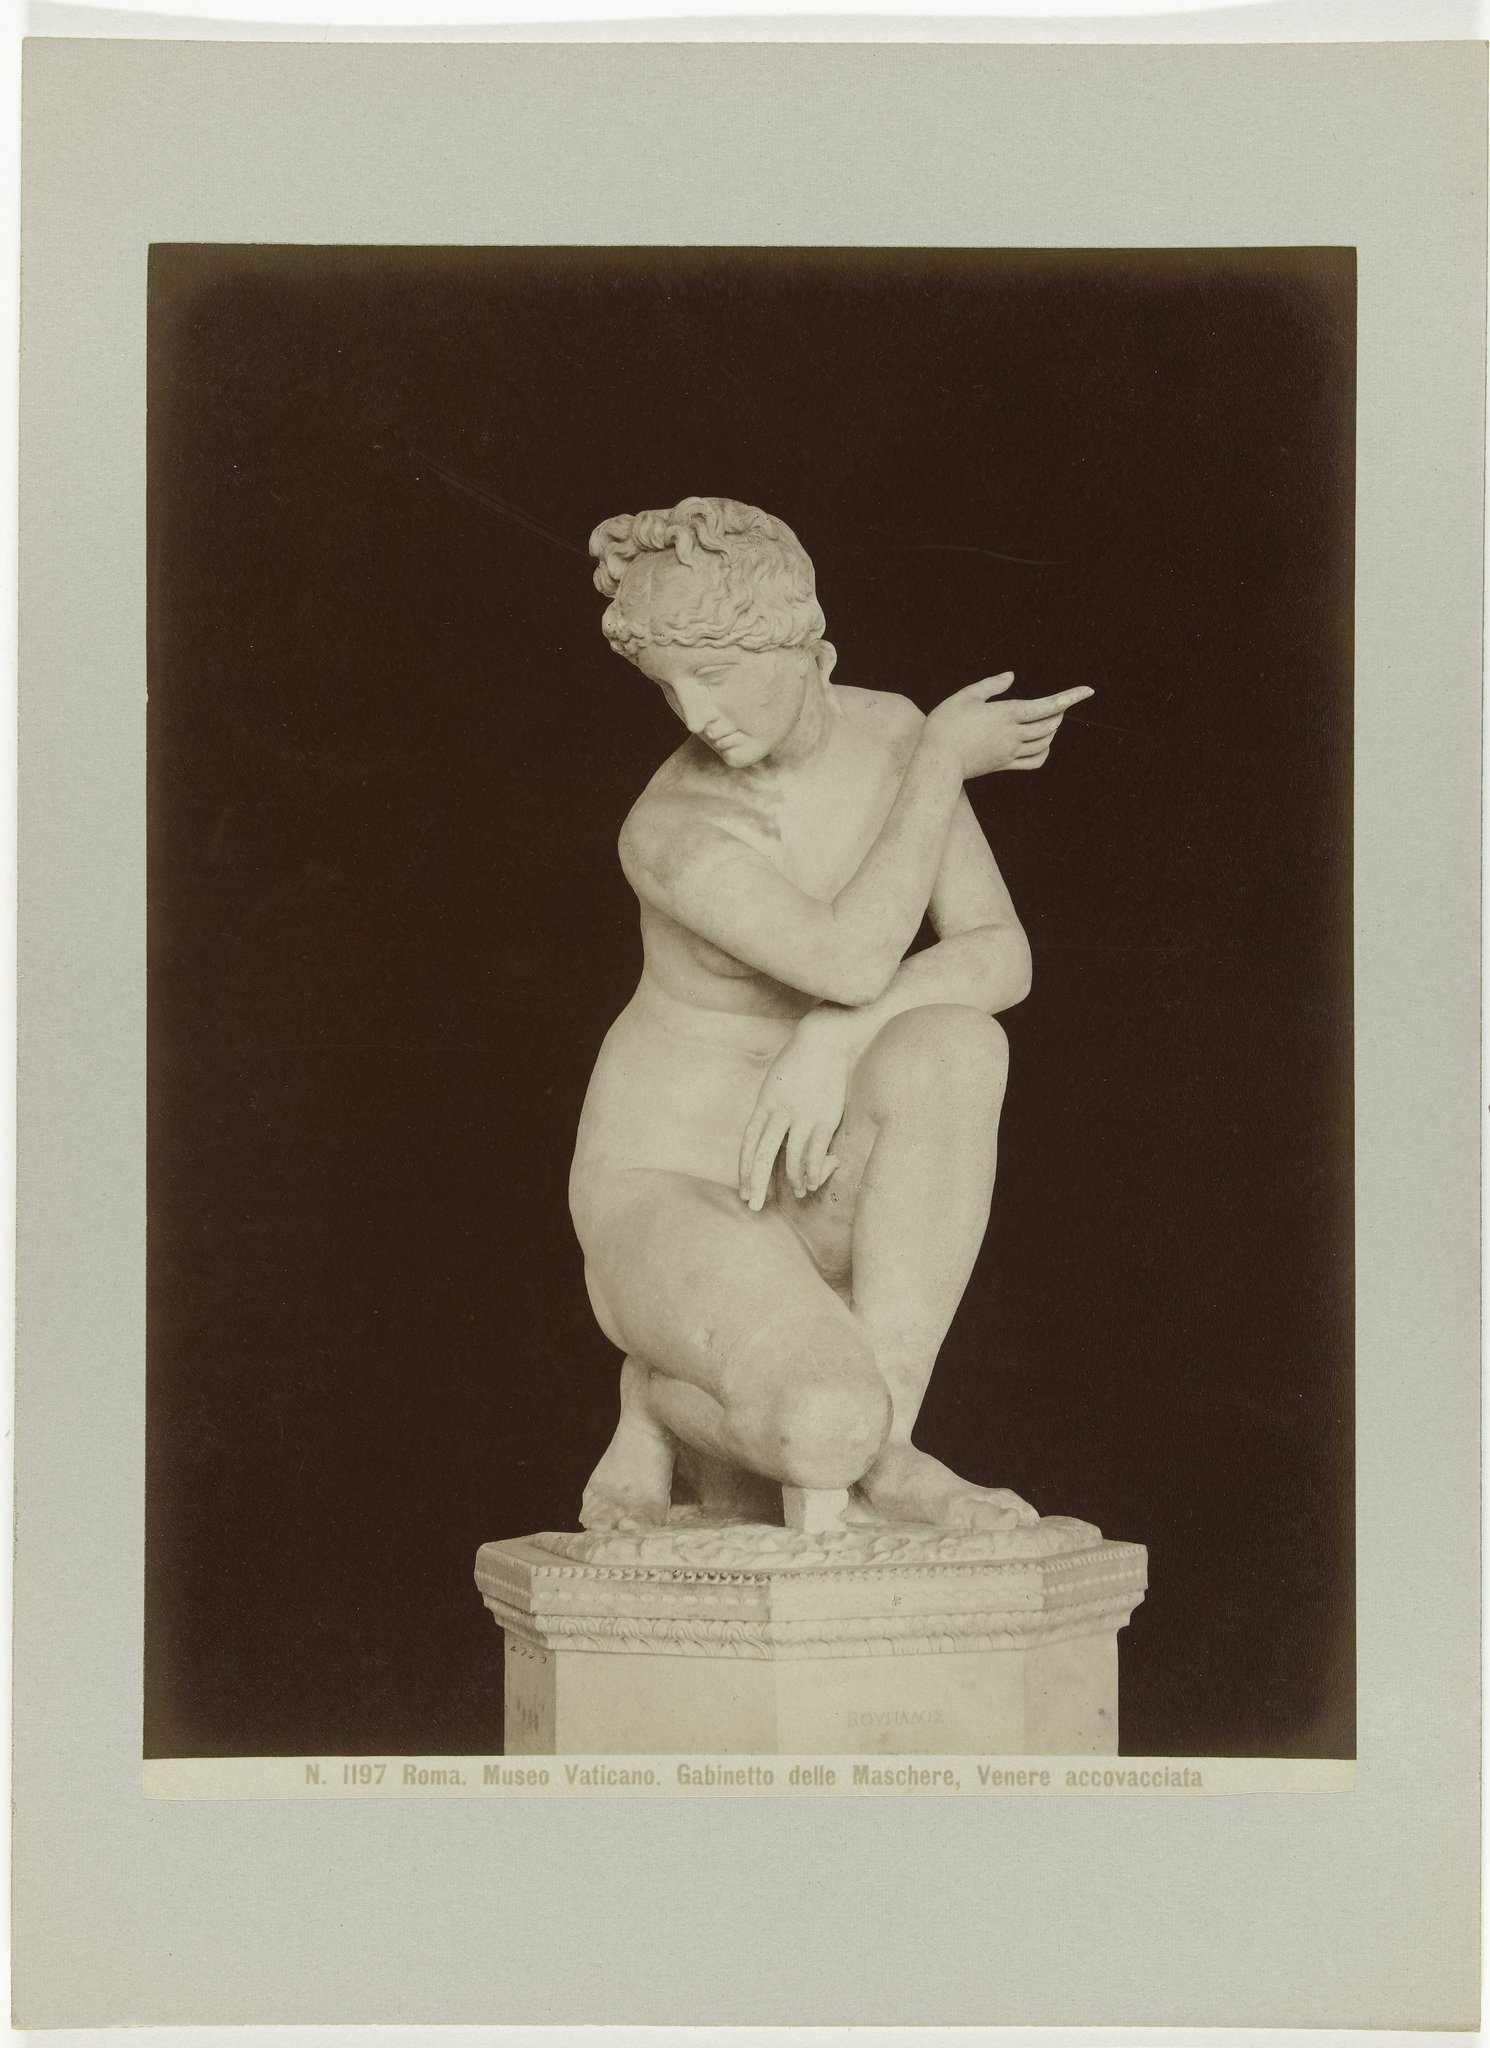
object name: photograph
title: Sculptuur van hurkende Venus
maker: Anonymous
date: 1880-1904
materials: cardboard, paper, photographic support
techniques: albumen print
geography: rome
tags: rome